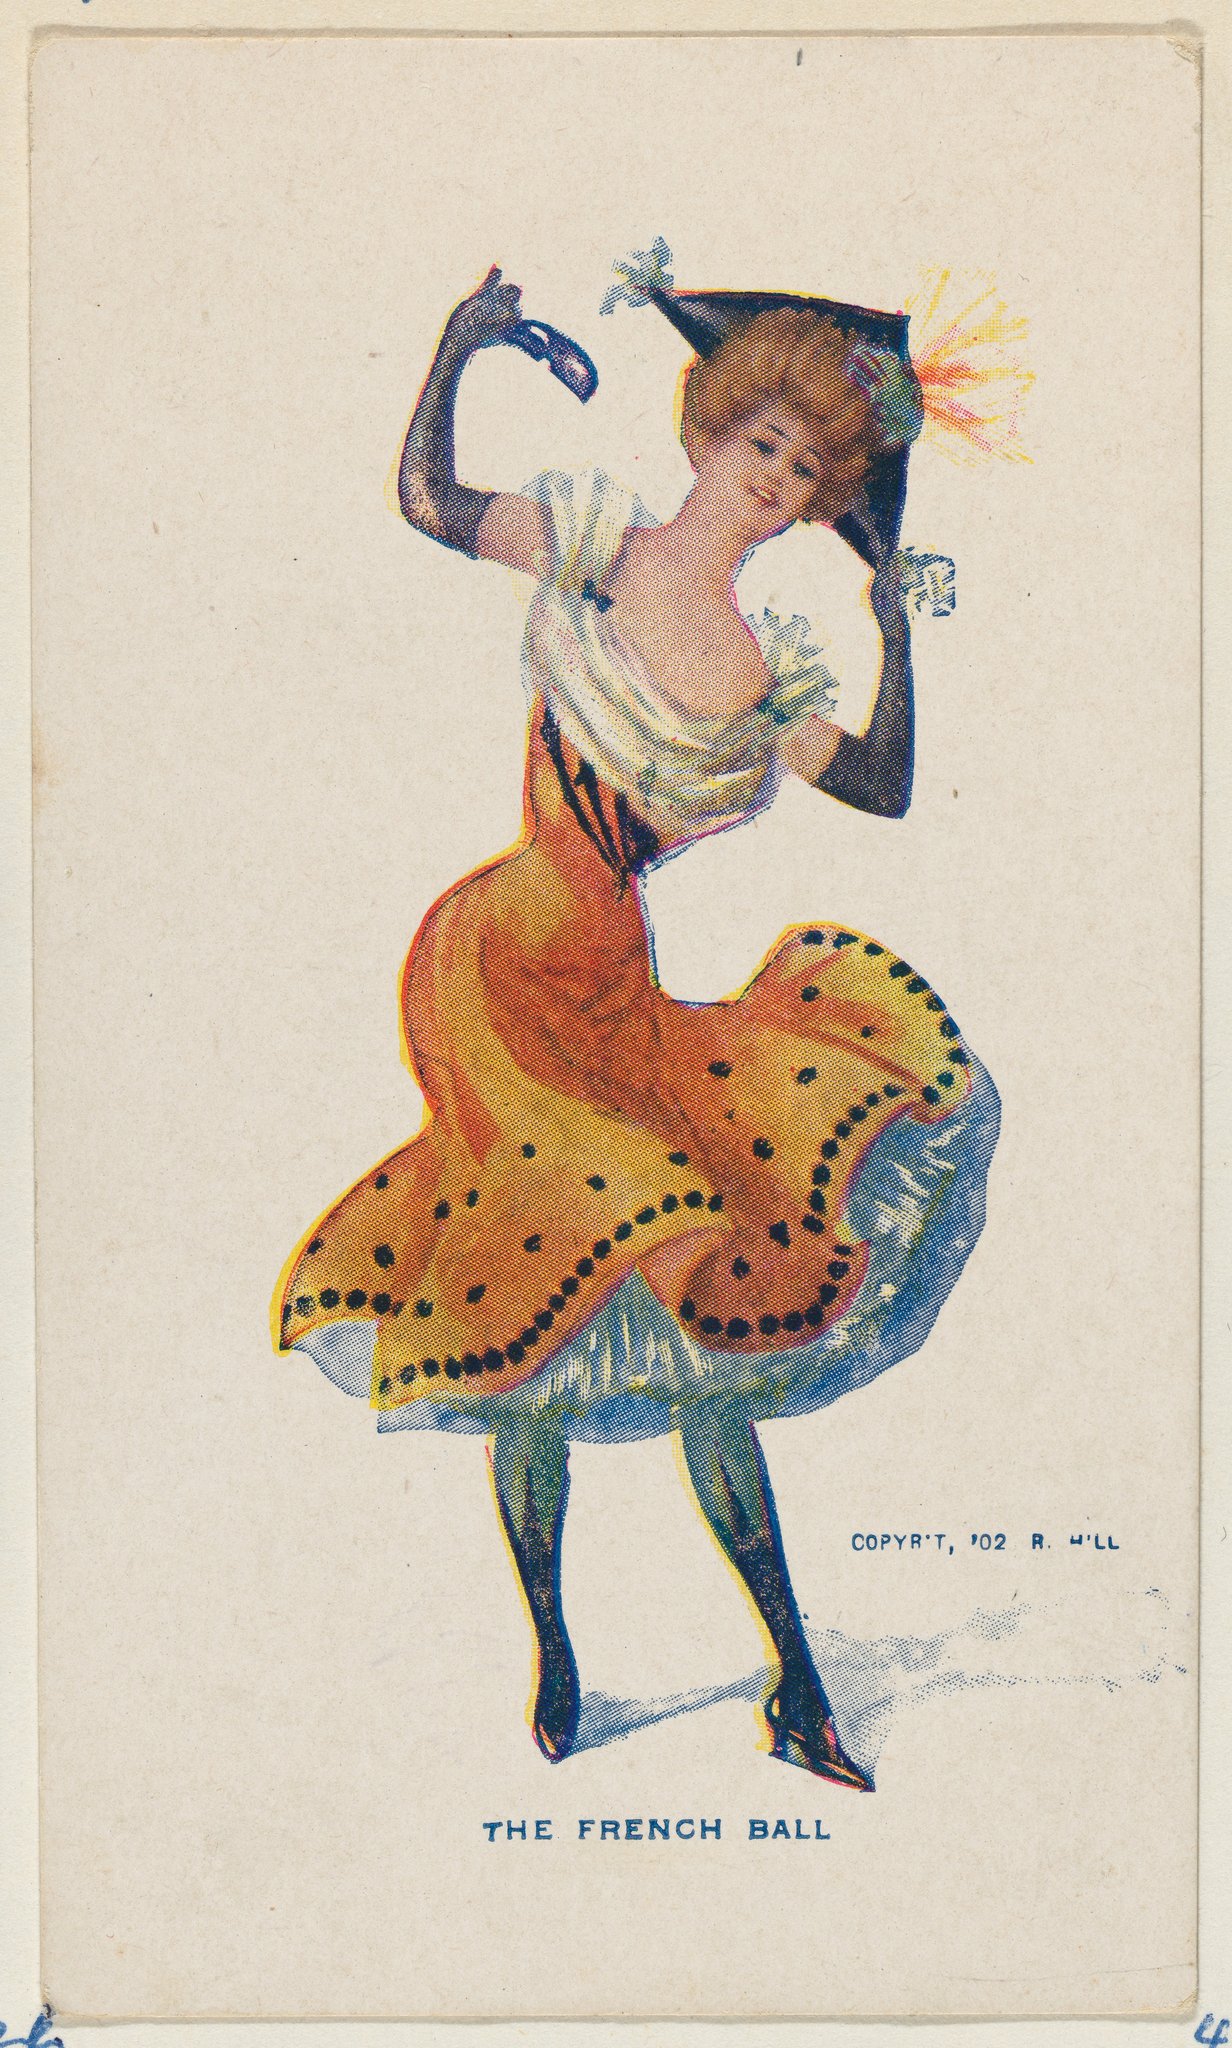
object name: print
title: The French Ball, from the "Girls and Men in Costume" series (T65), issued with Golden Eagle Cigars by I. Lewis & Co.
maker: i. lewis & co., newark, new jersey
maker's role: publisher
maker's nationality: american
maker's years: 1850-1950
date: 1903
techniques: color lithograph